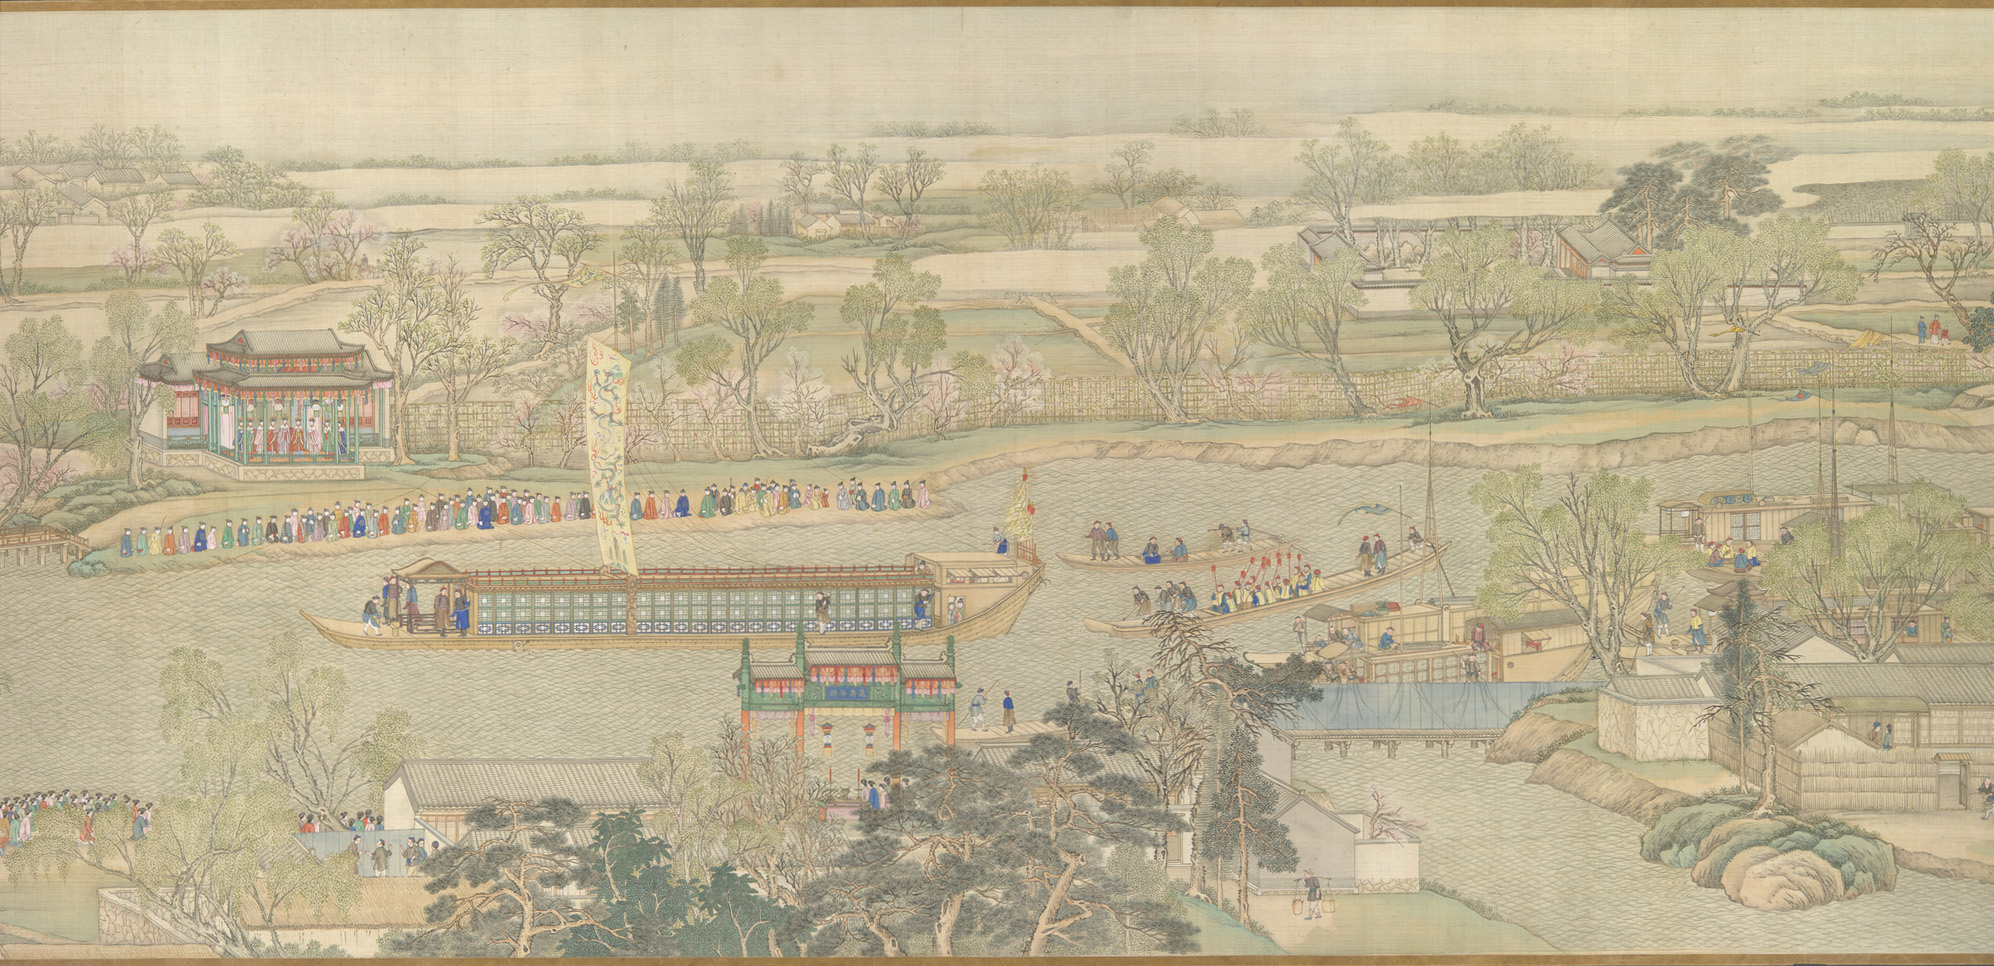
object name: handscroll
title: The Qianlong Emperor's Southern Inspection Tour, Scroll Six: Entering Suzhou along the Grand Canal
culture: chinese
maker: xu yang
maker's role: artist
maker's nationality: chinese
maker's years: 1750-1776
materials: ink, silk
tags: canals,landscapes,boats